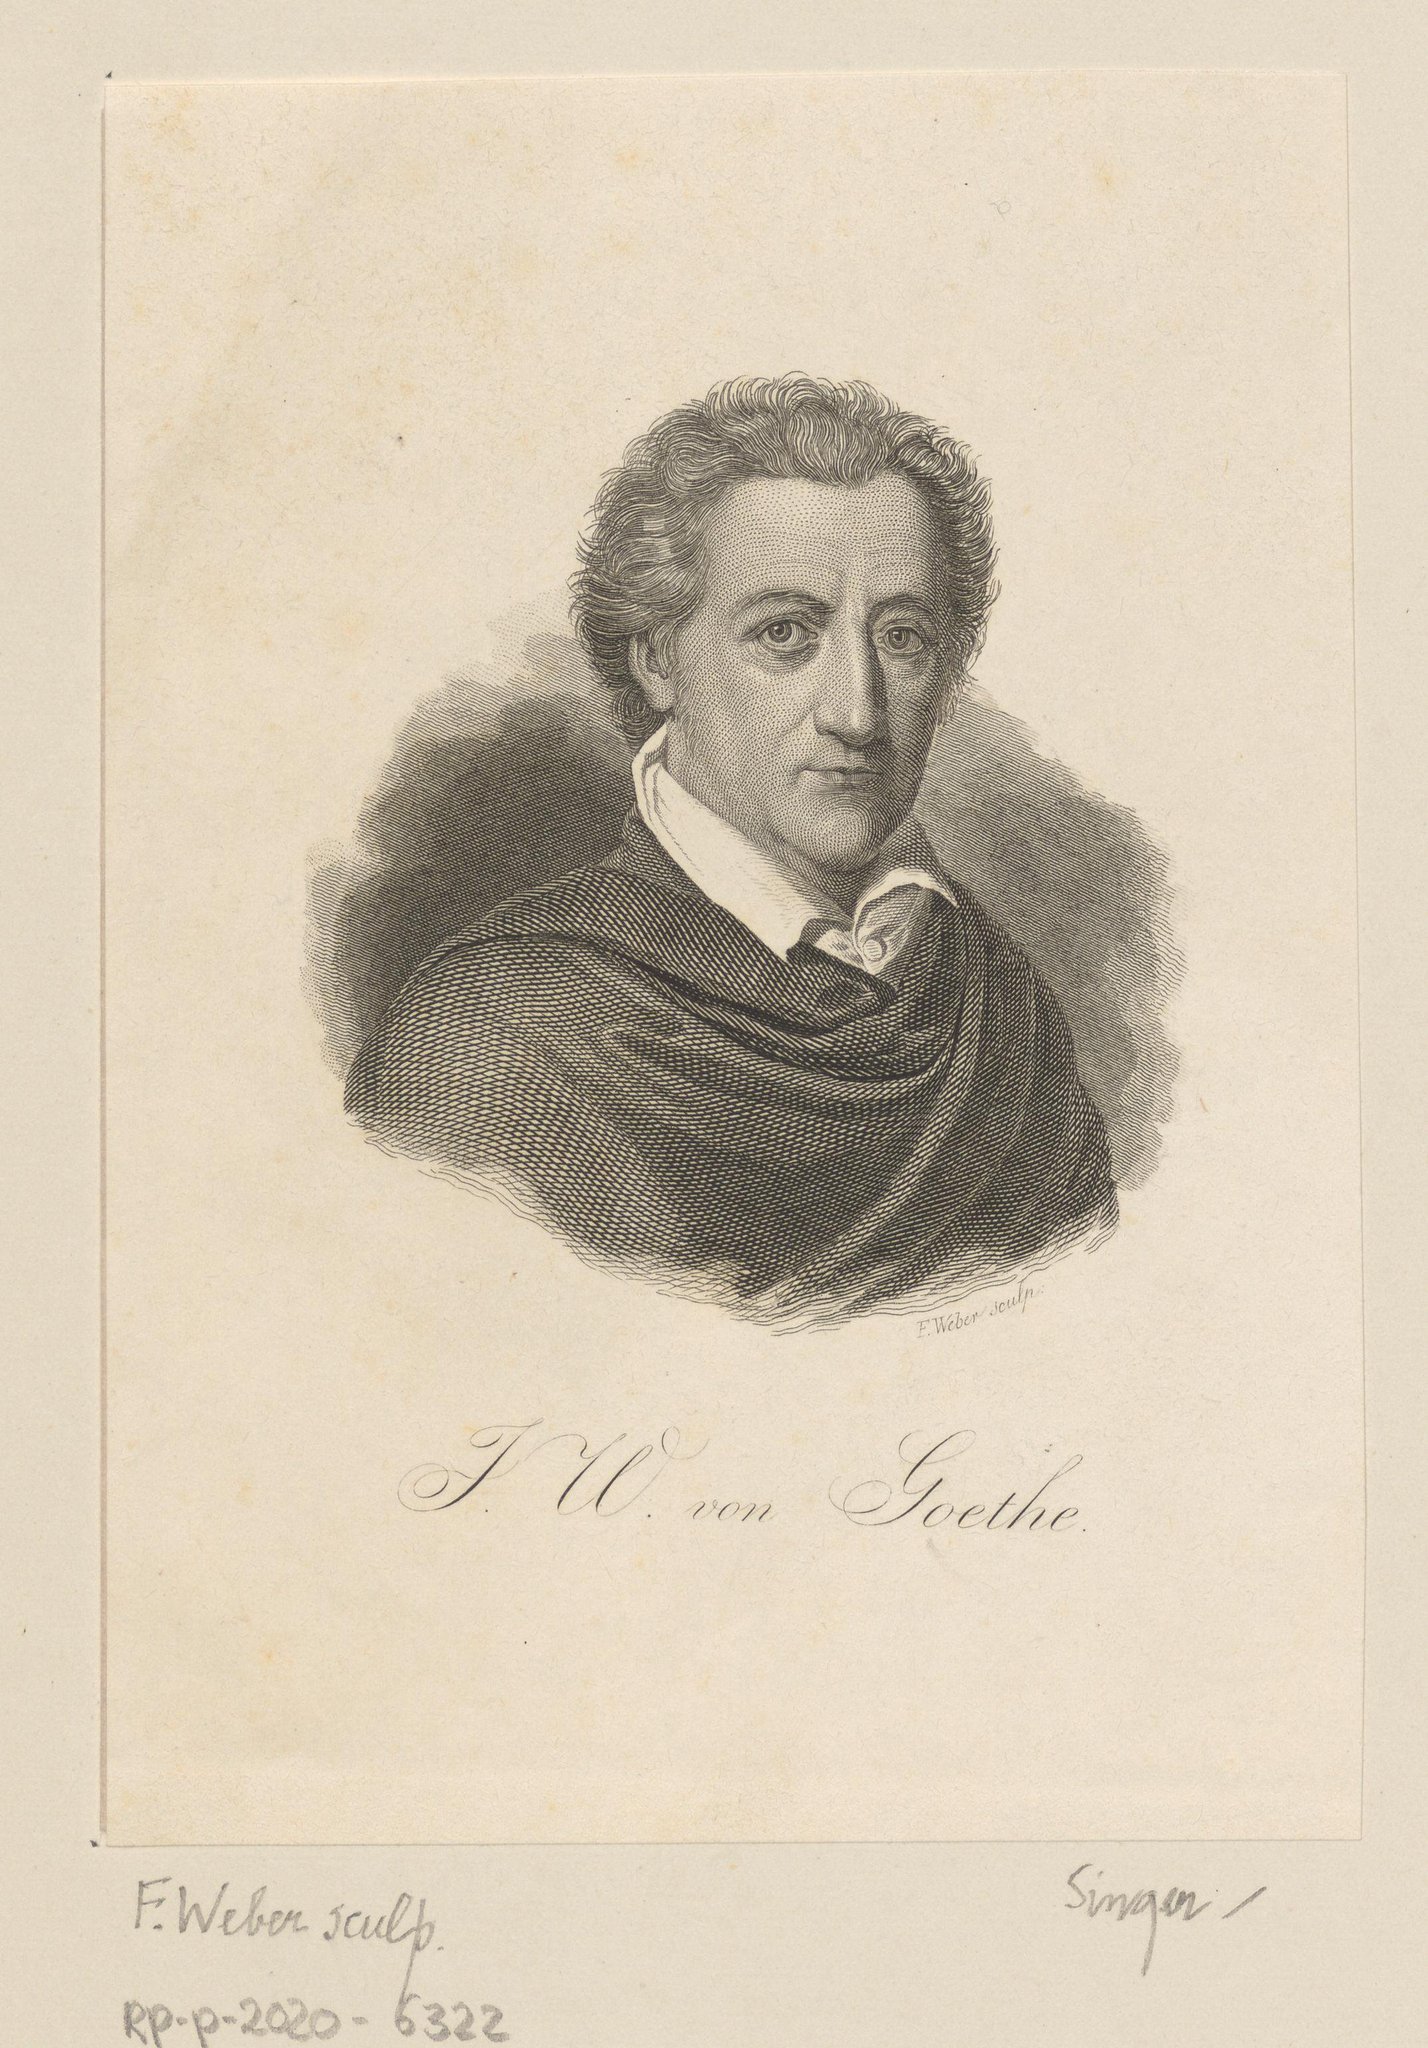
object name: print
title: Portret van Johann Wolfgang von Goethe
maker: friedrich weber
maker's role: print maker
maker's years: 1813-1882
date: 1823-1882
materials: paper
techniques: engraving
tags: johann wolfgang von goethe, historical persons, portrait of a writer